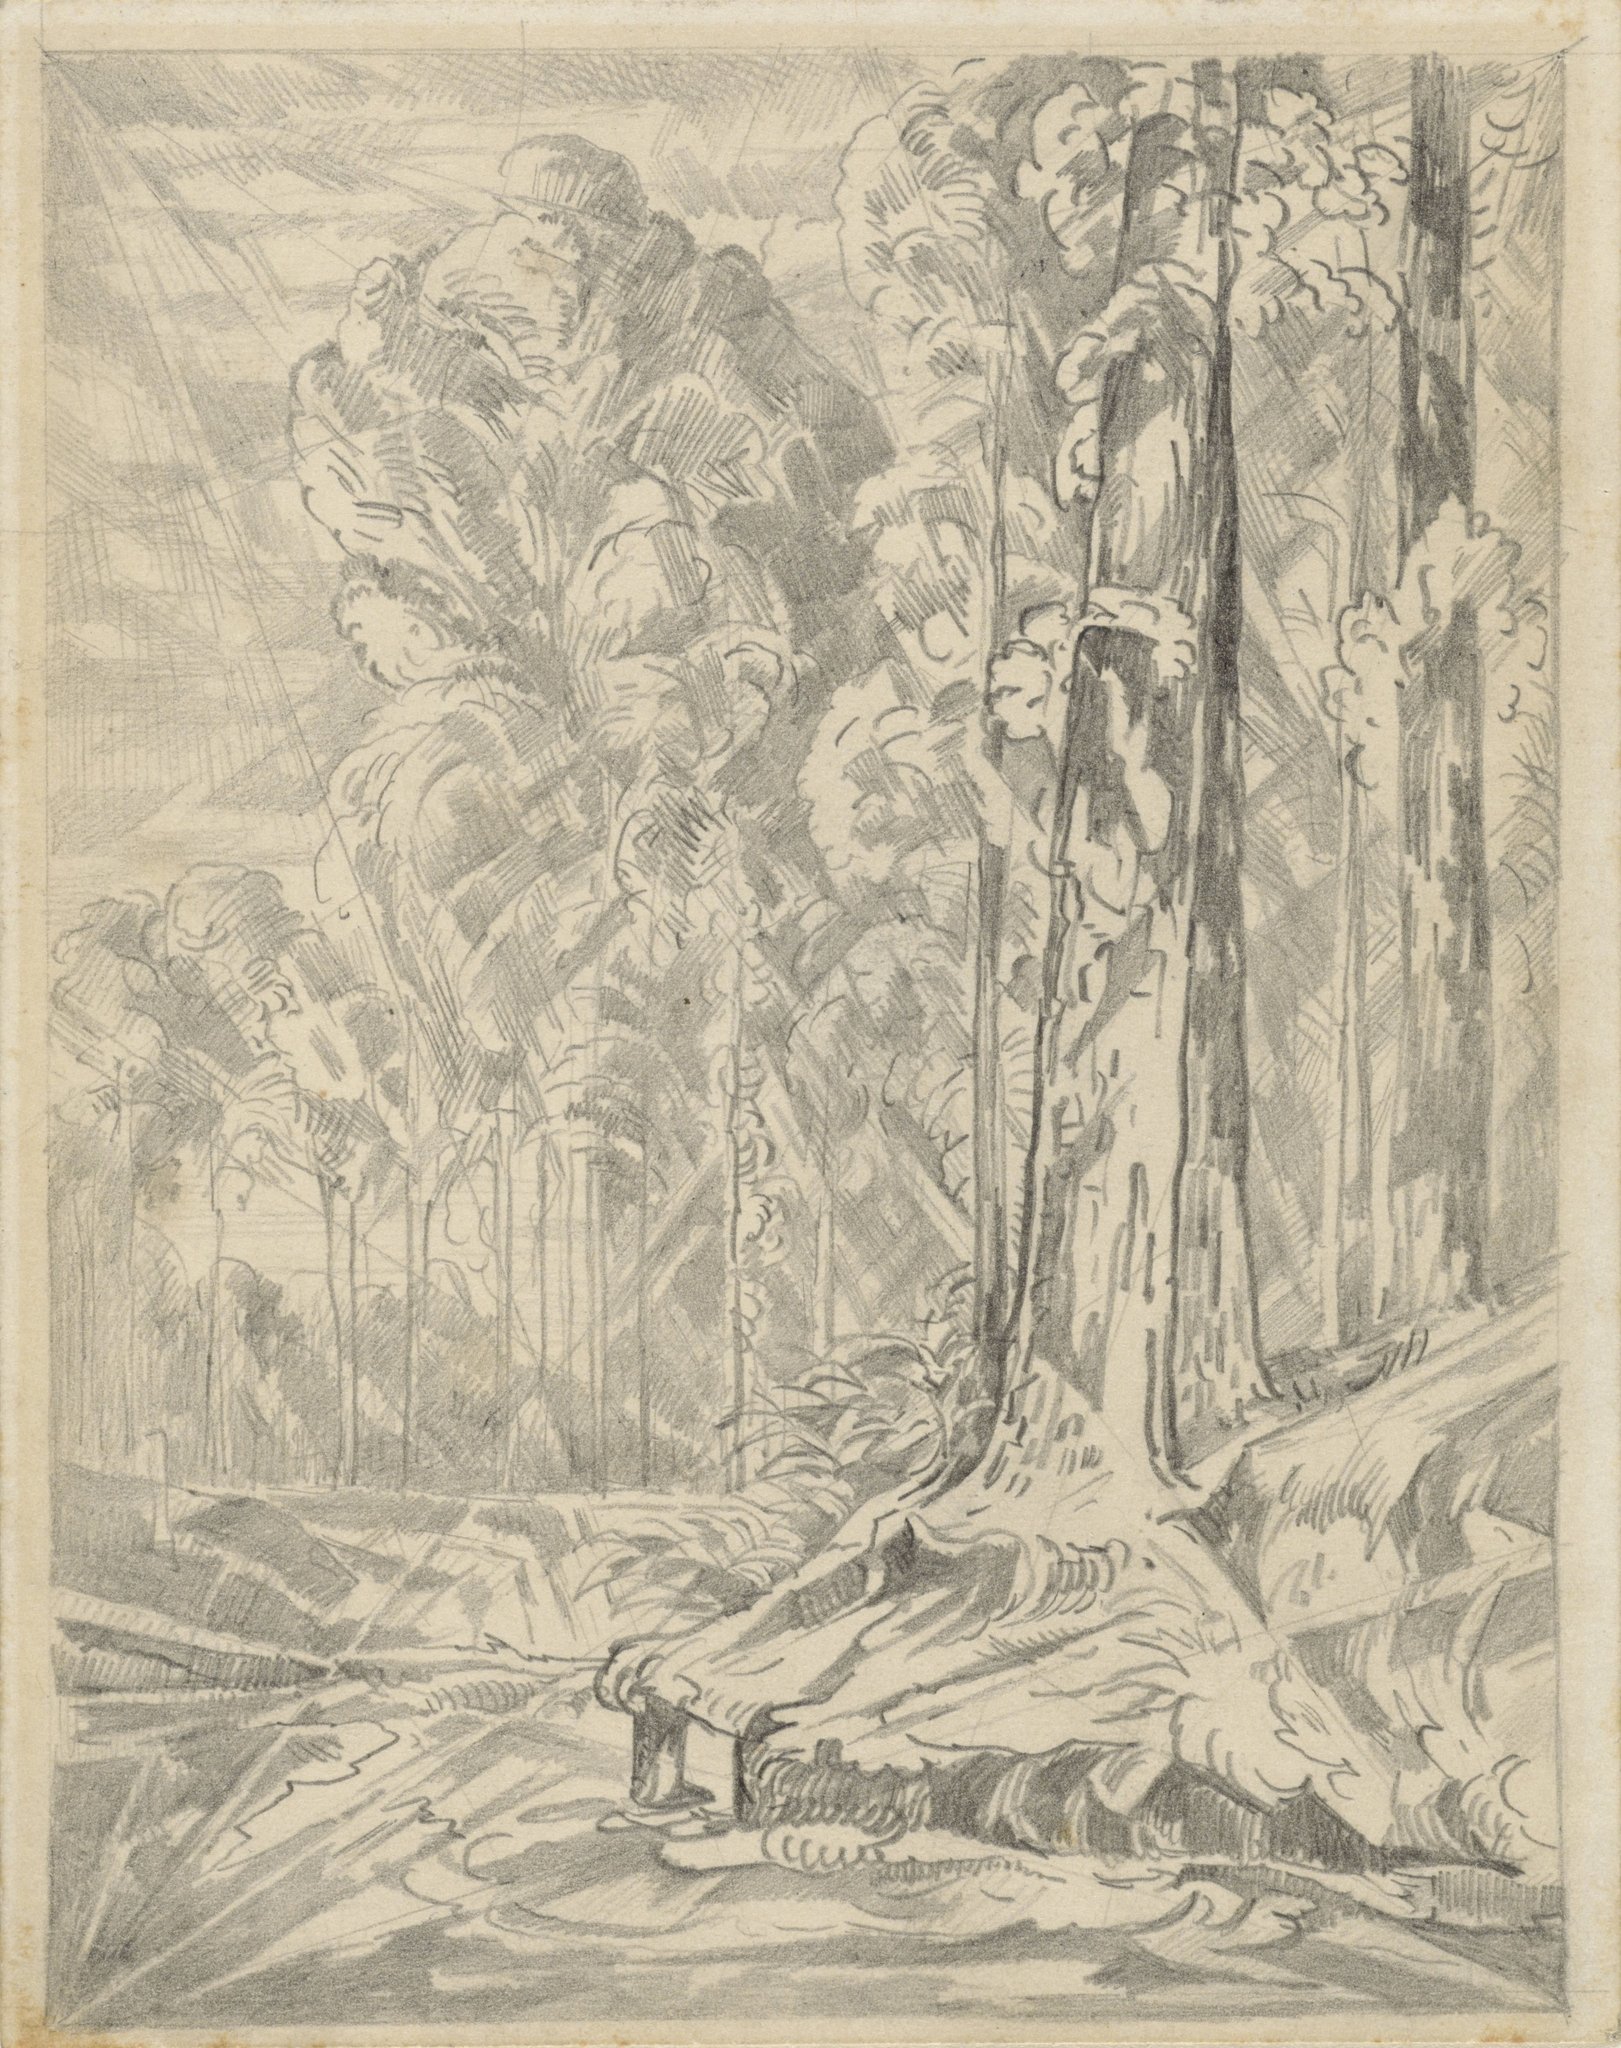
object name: drawing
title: Open plek tussen hoog geboomte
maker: willem van konijnenburg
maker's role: draughtsman, painter, print maker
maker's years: 1868-1943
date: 1878-1943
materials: paper, pencil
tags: forest, wood